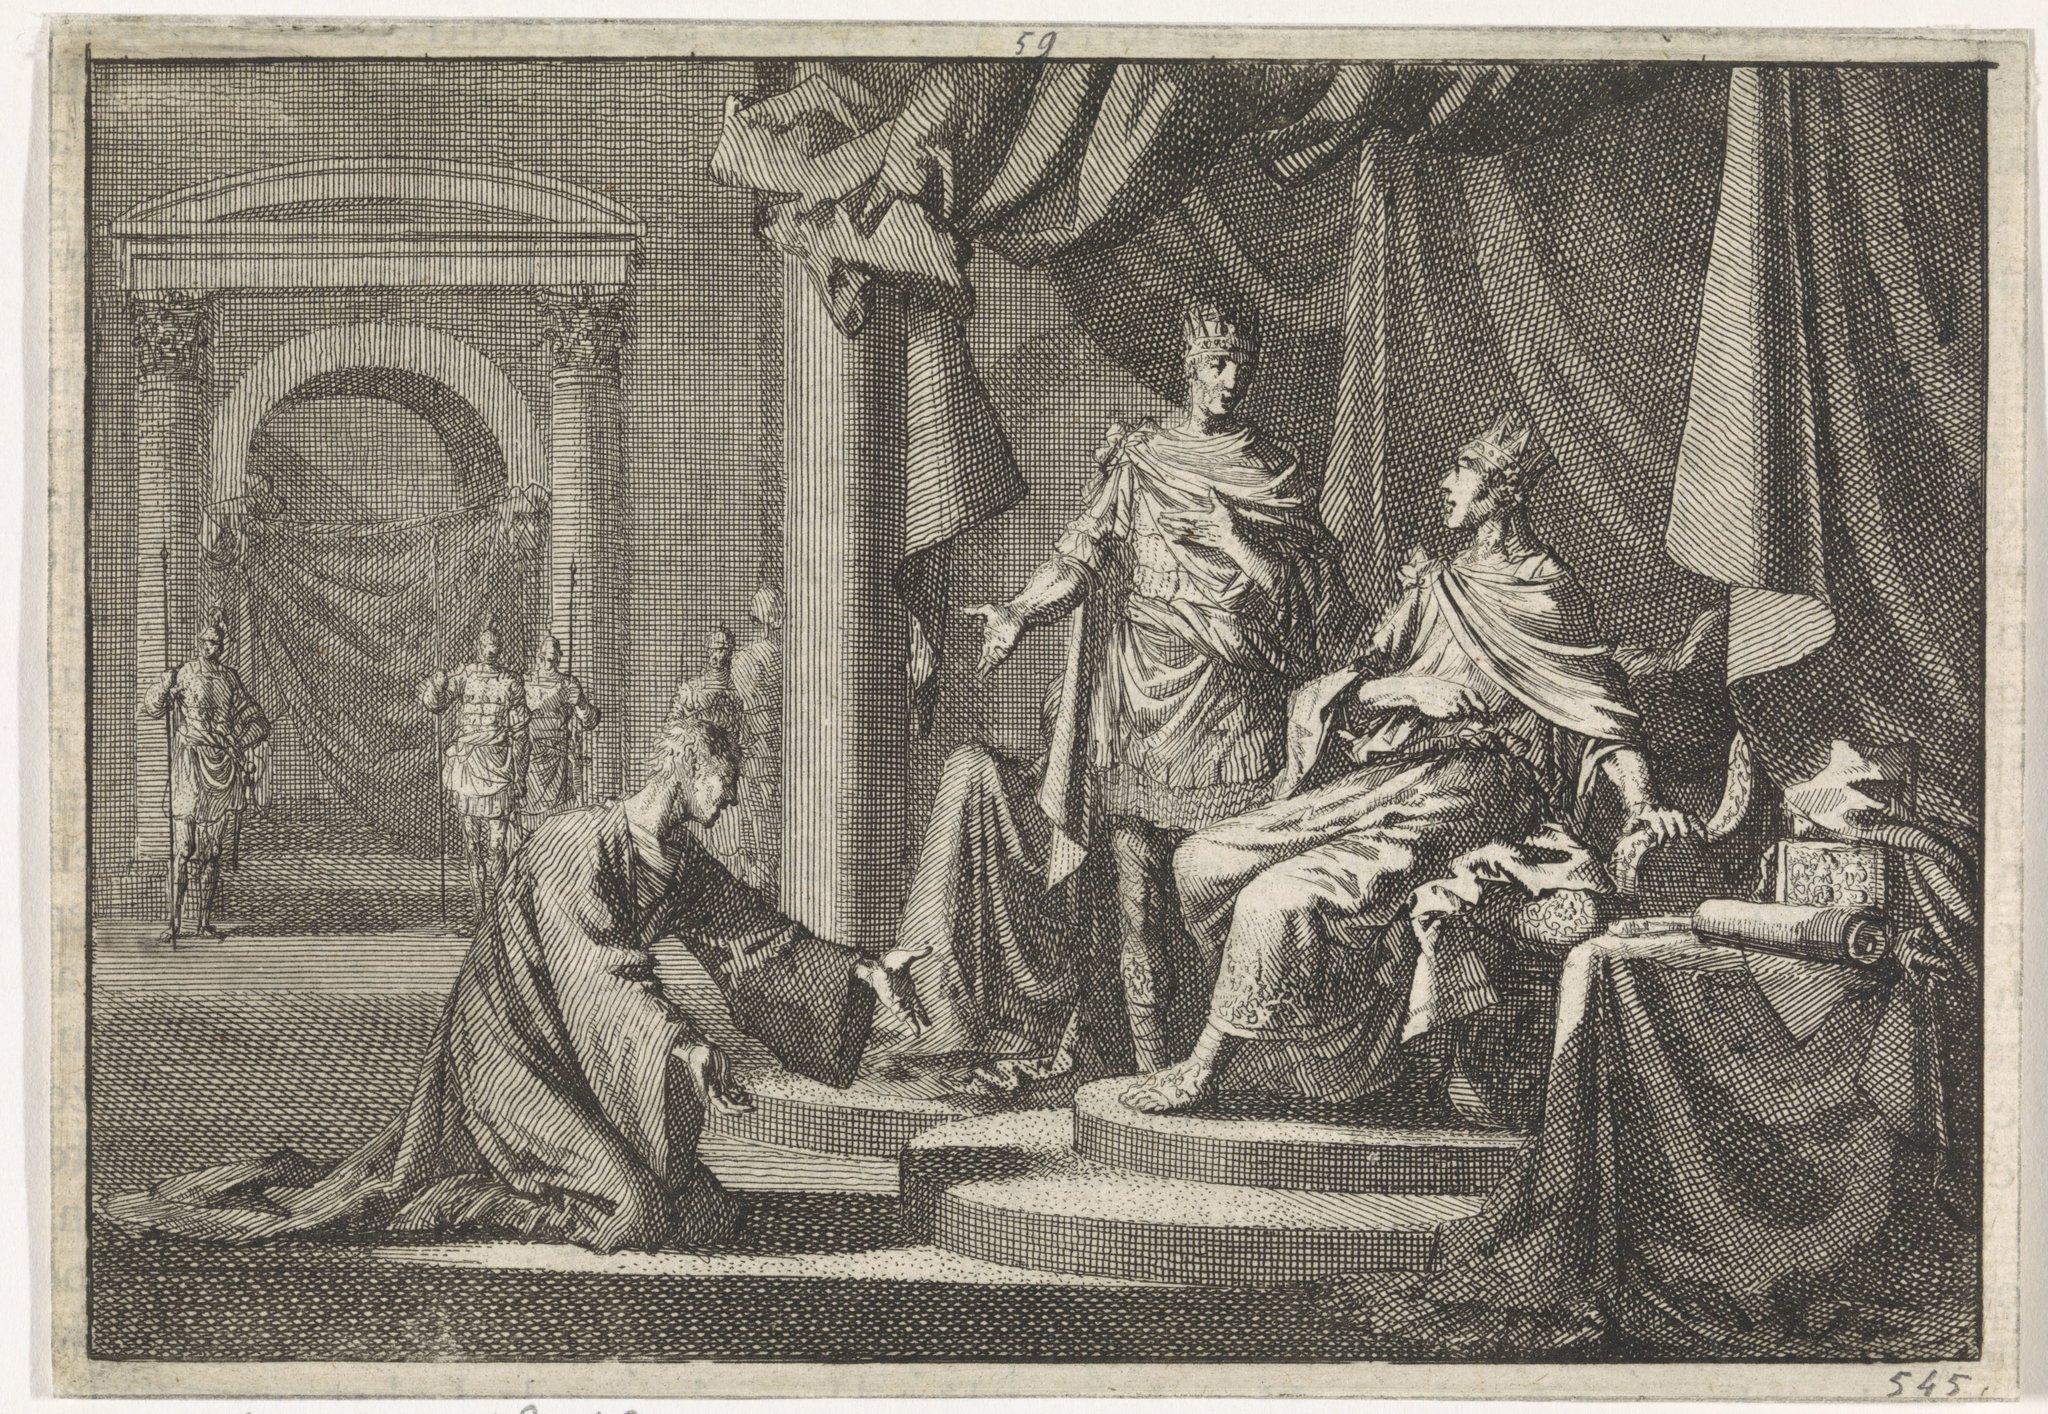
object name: print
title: Pheroras knielt in boetekleed voor zijn broer Herodes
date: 1704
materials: paper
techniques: etching, letterpress printing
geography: amsterdam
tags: kneeling before a ruler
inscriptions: collector's mark: Lugt 2228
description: Prent opgenomen in: Josephus, Flavius. Alle de Werken, 2 delen. Amsterdam: Pieter Mortier, 1704, dl. 2, p. 545.